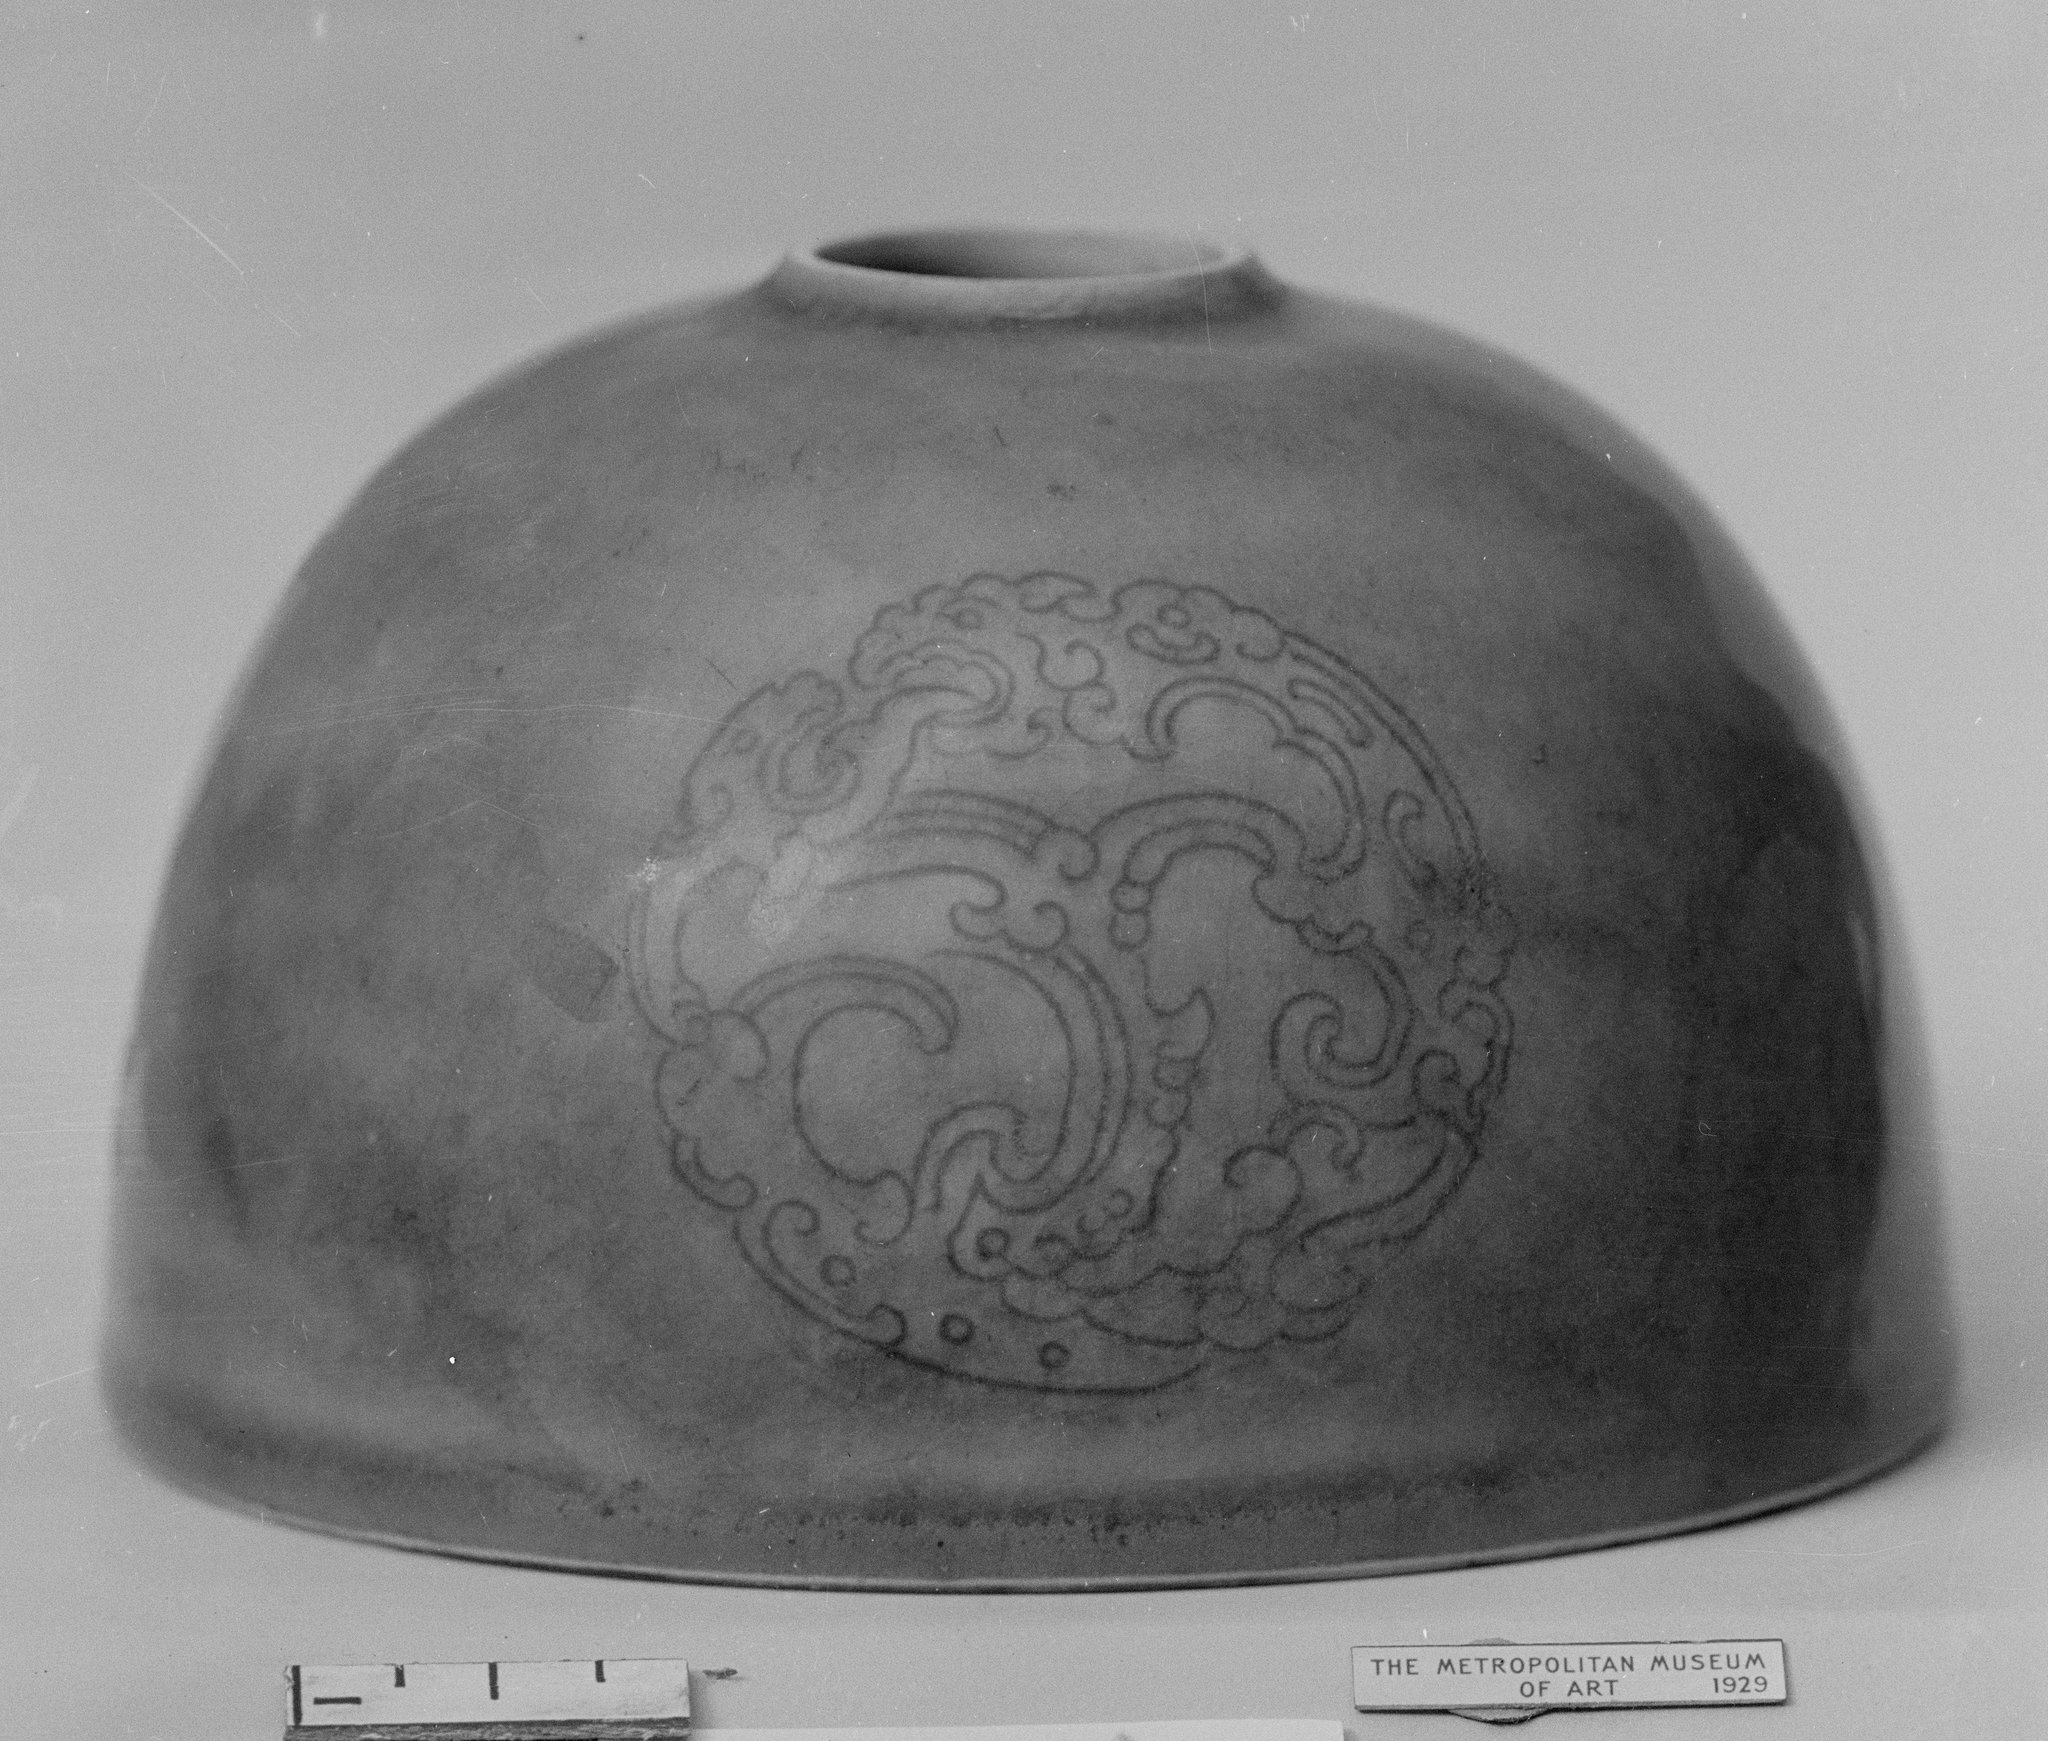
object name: water coupe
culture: chinese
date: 1662-1722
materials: glaze, porcelain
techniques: incising